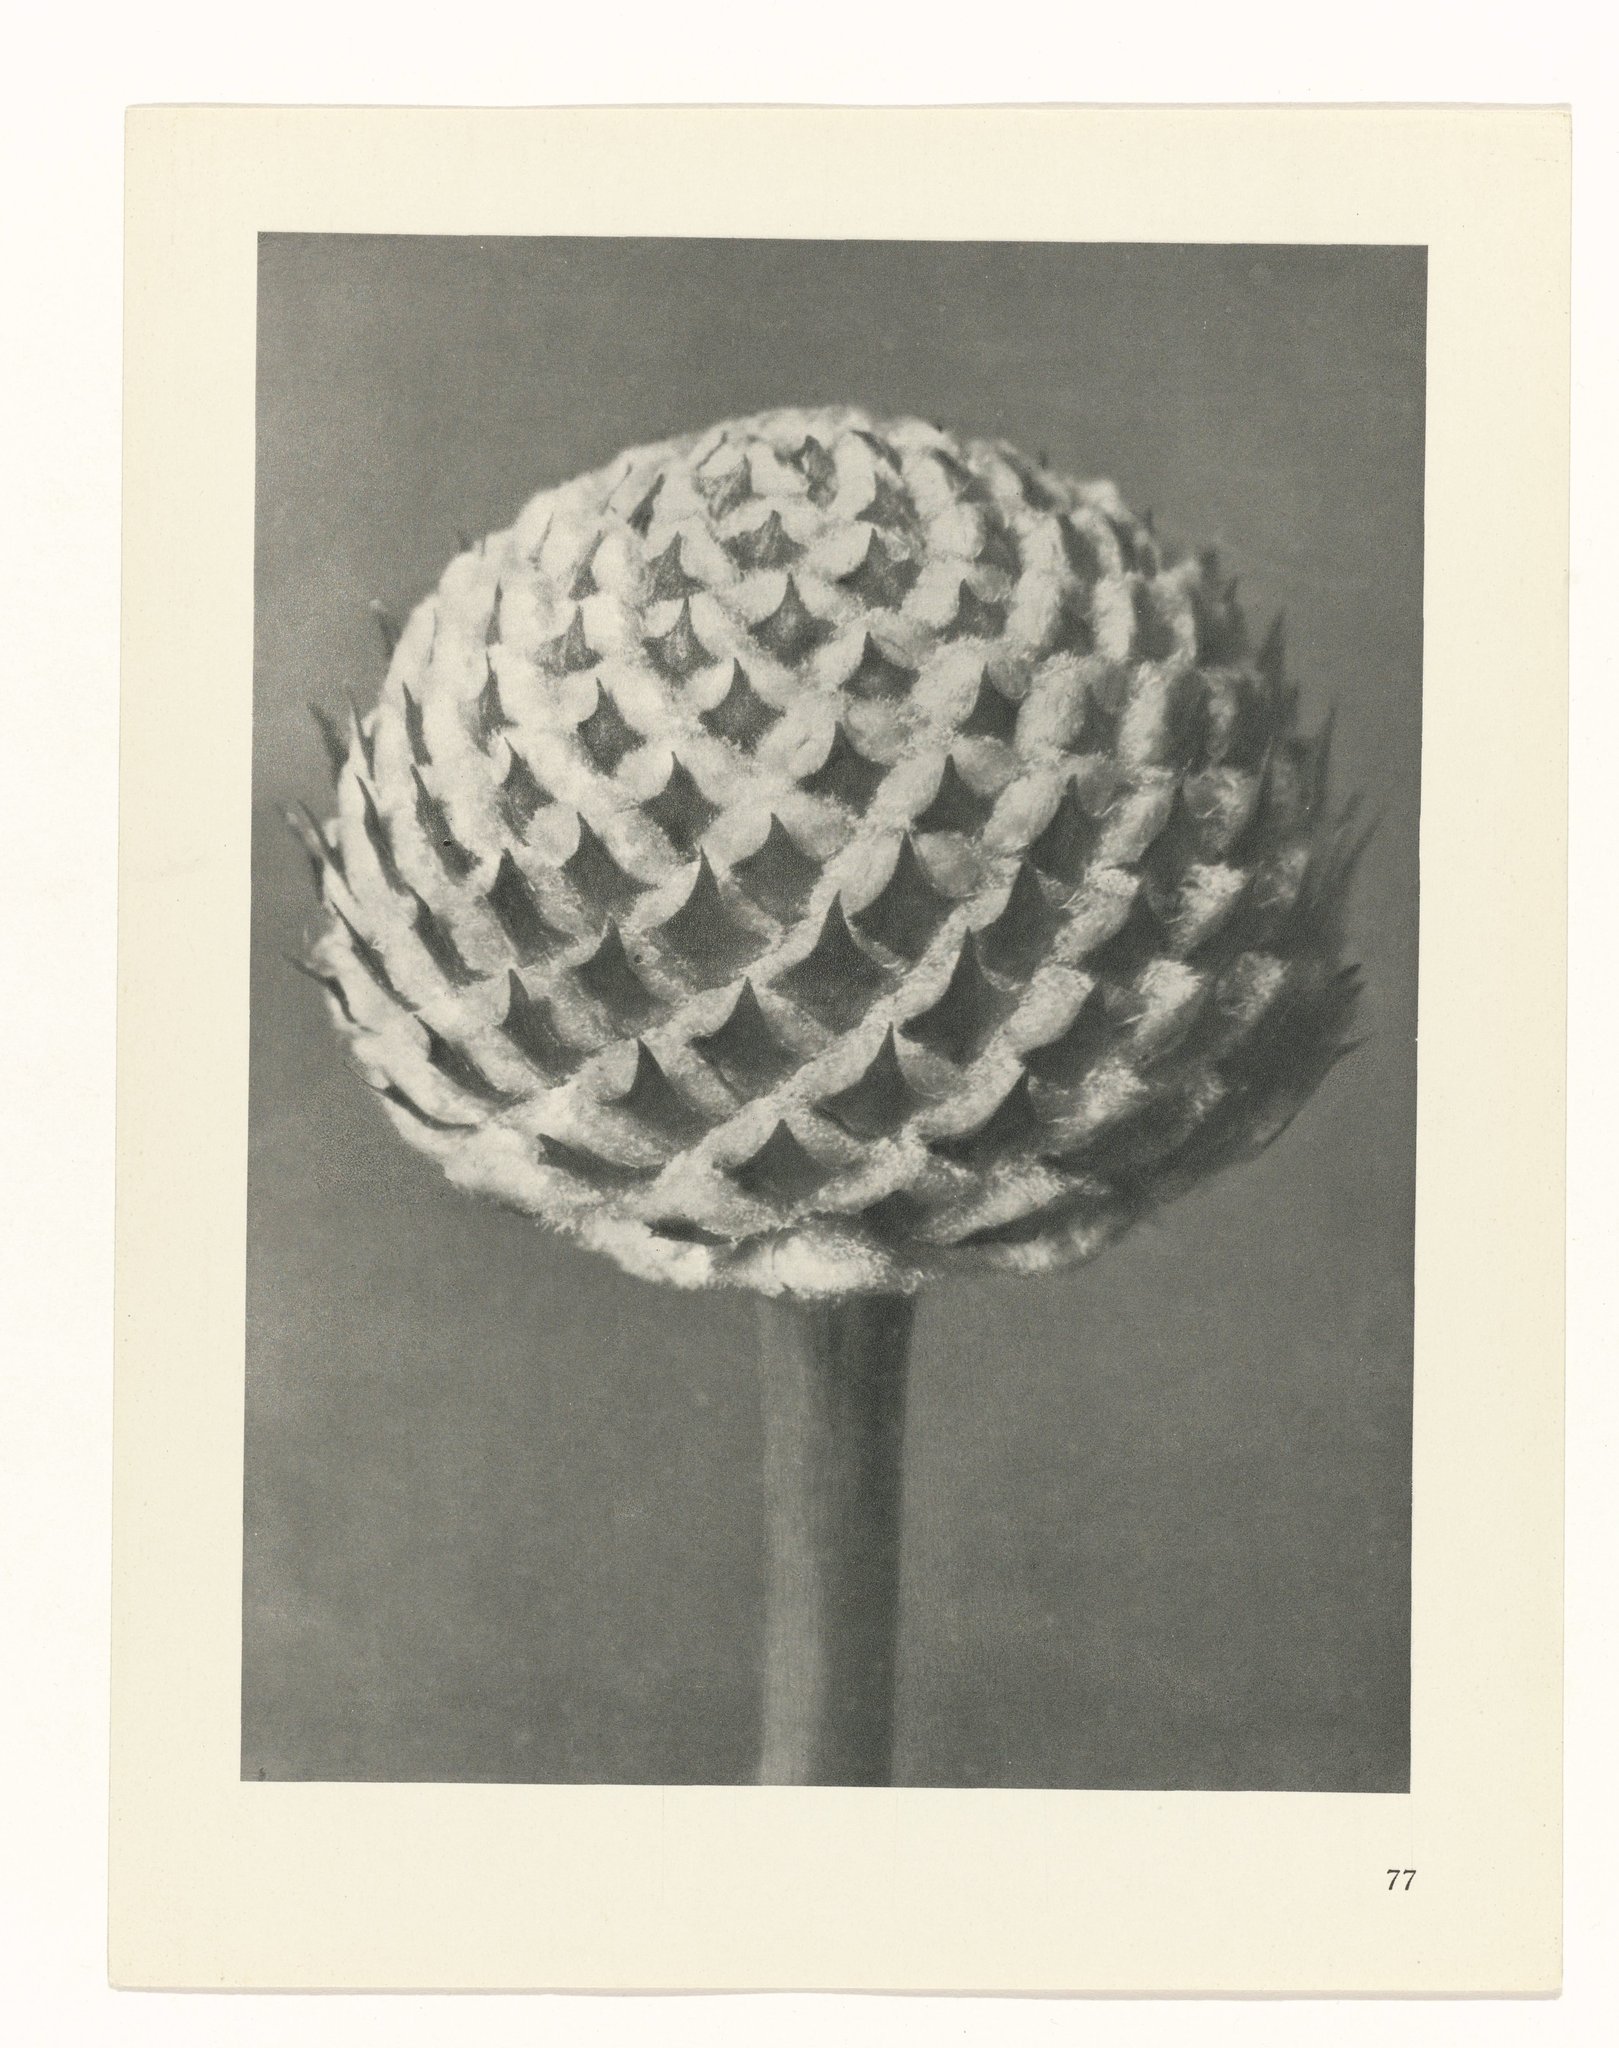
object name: photograph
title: Plantstudie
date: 1928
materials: ink, paper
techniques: rotogravure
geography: berlin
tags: plants (in general)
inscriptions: number: ‘77’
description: facher Vergrößerung. Afkomstig uit losbladige uitgave.